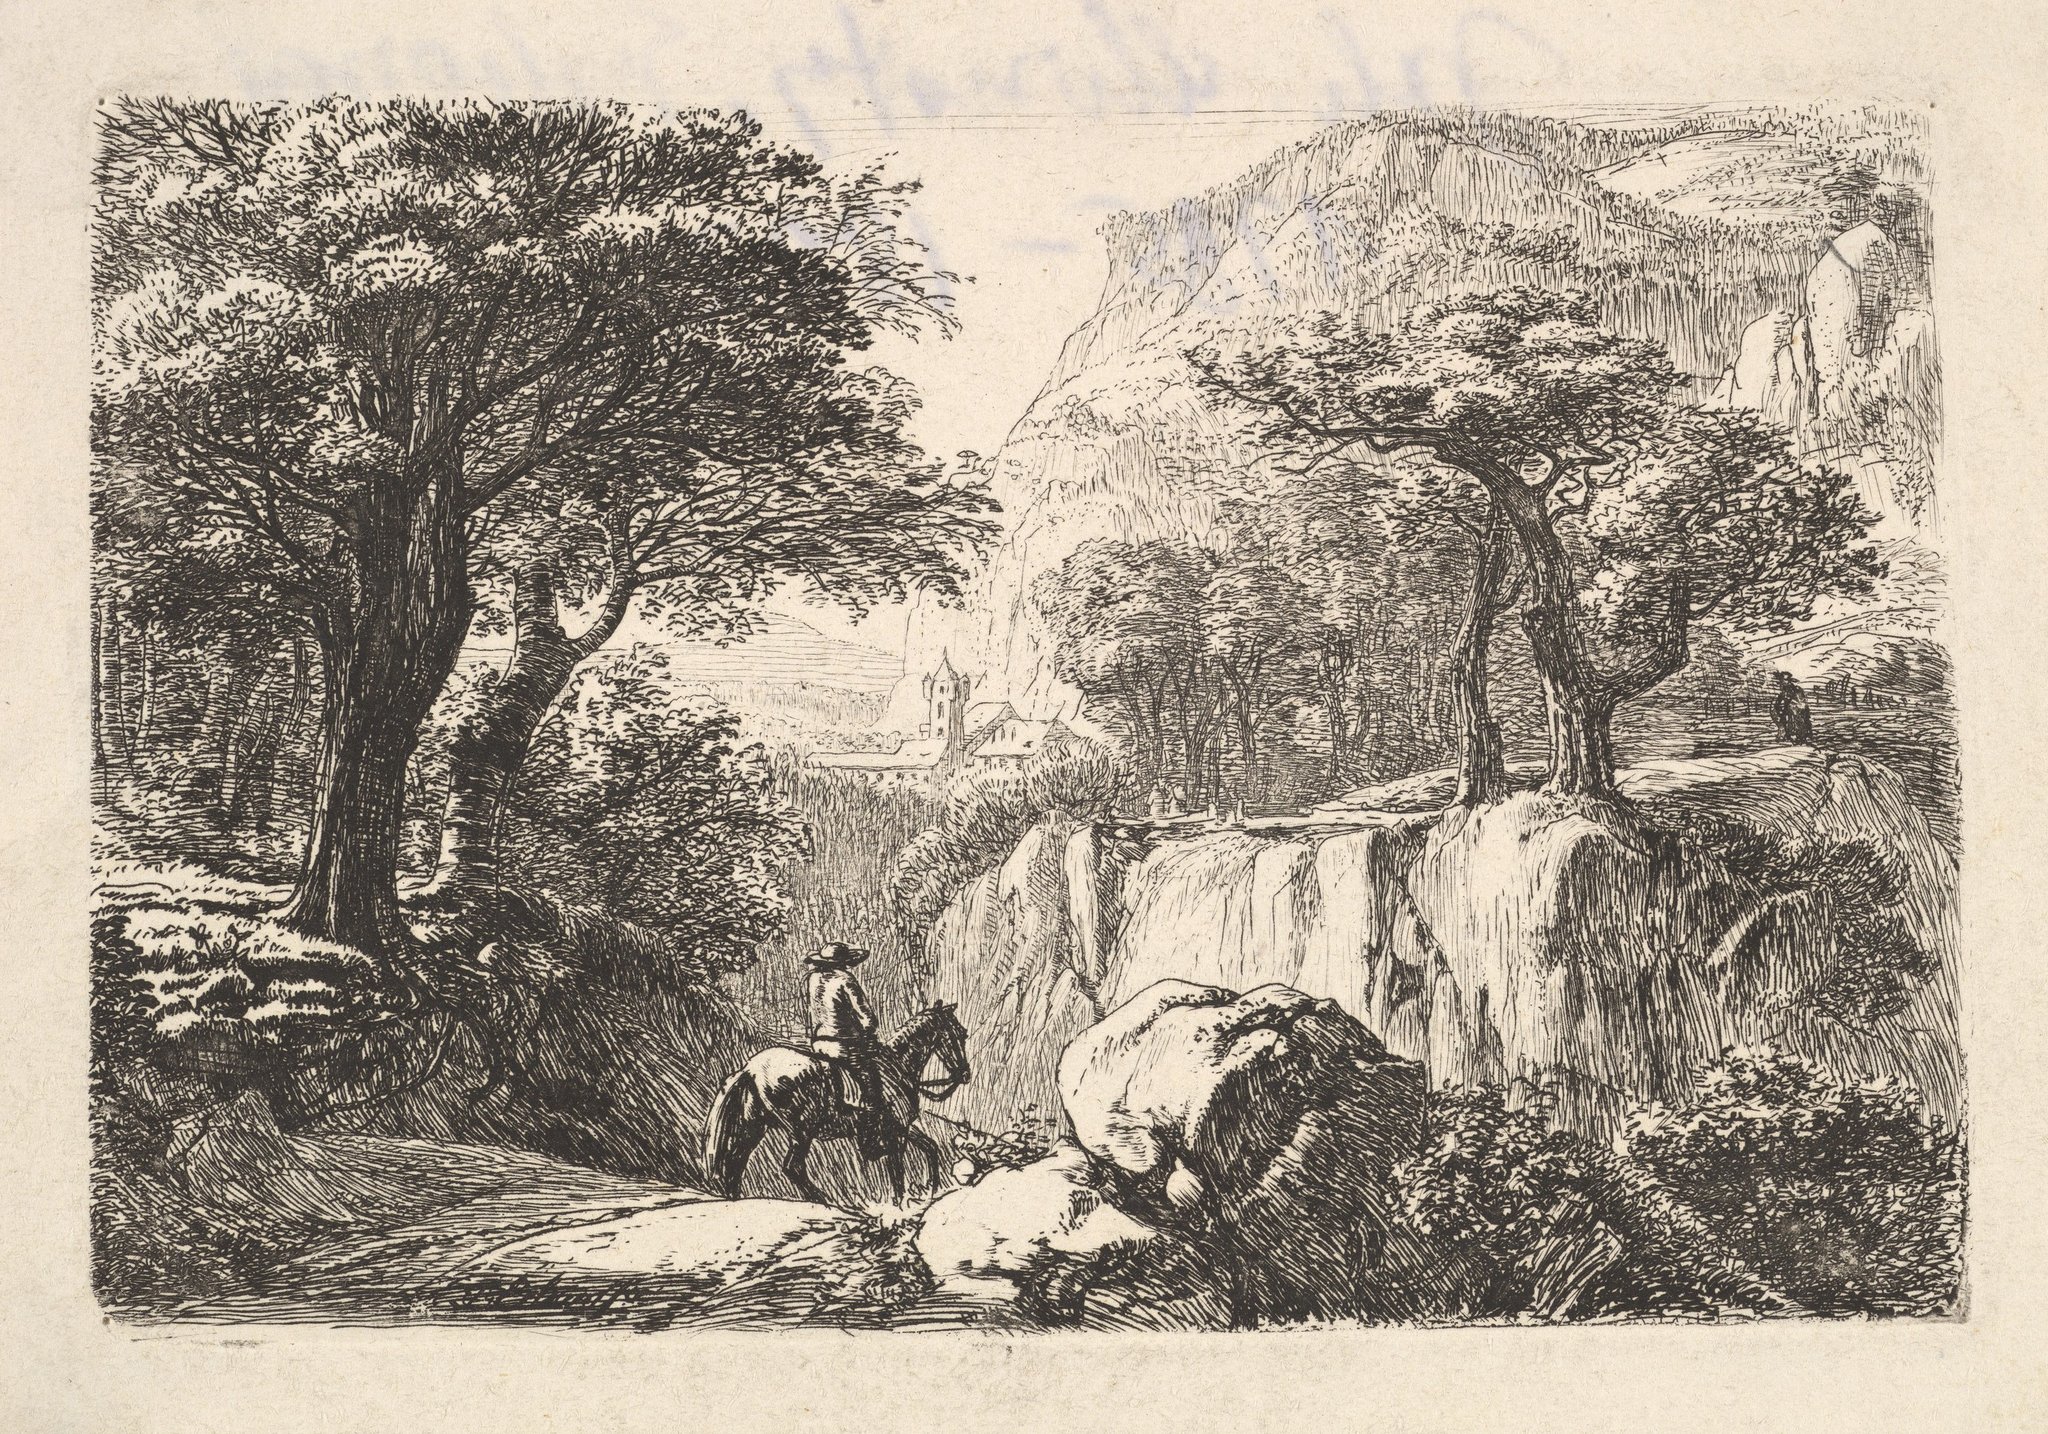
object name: print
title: The Horseback Rider in the Gorge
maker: johann christoph erhard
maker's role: artist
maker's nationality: german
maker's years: 1795-1822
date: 1801-1900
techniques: etching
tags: horses,trees